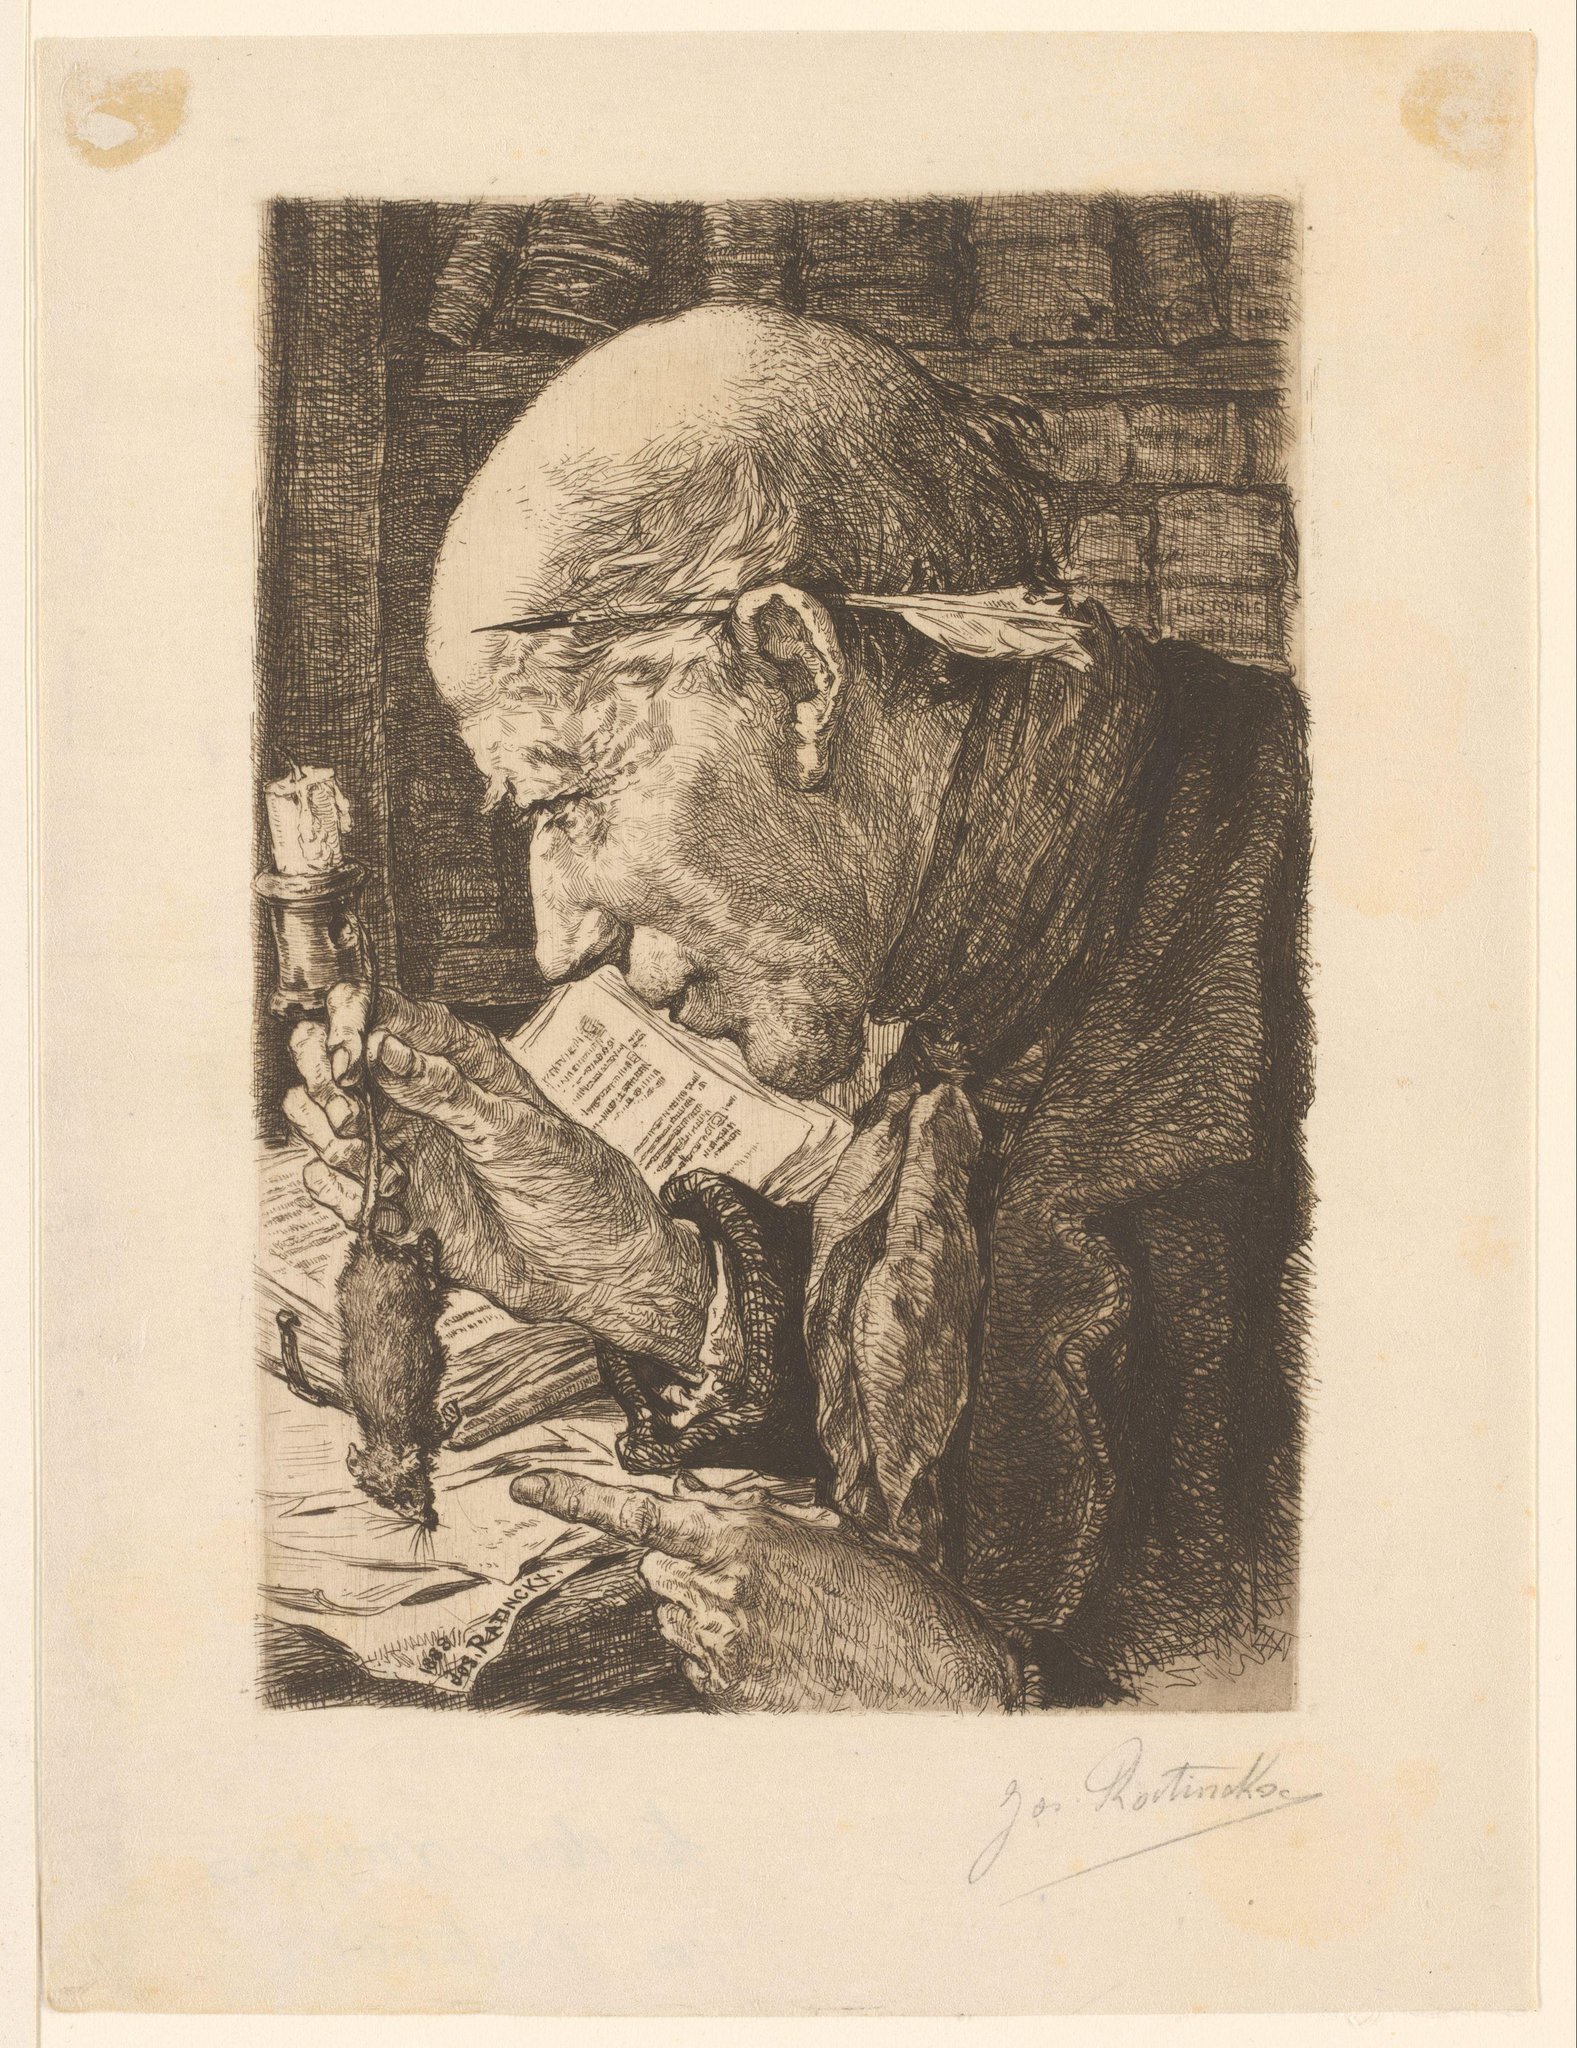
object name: print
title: Man gezeten voor een boekenkast met een schrijfveer achter zijn oor en een muis in zijn hand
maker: jos ratinckx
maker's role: print maker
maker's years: 1860-1937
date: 1888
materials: paper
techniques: etching, intaglio, retroussage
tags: quill, rodents: mouse, book - mm - book open, old man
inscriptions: mark: ‘Antwerpsche Etsers 1880’, inscription: ‘Les deux rongeurs’, collector's mark: Lugt 2228